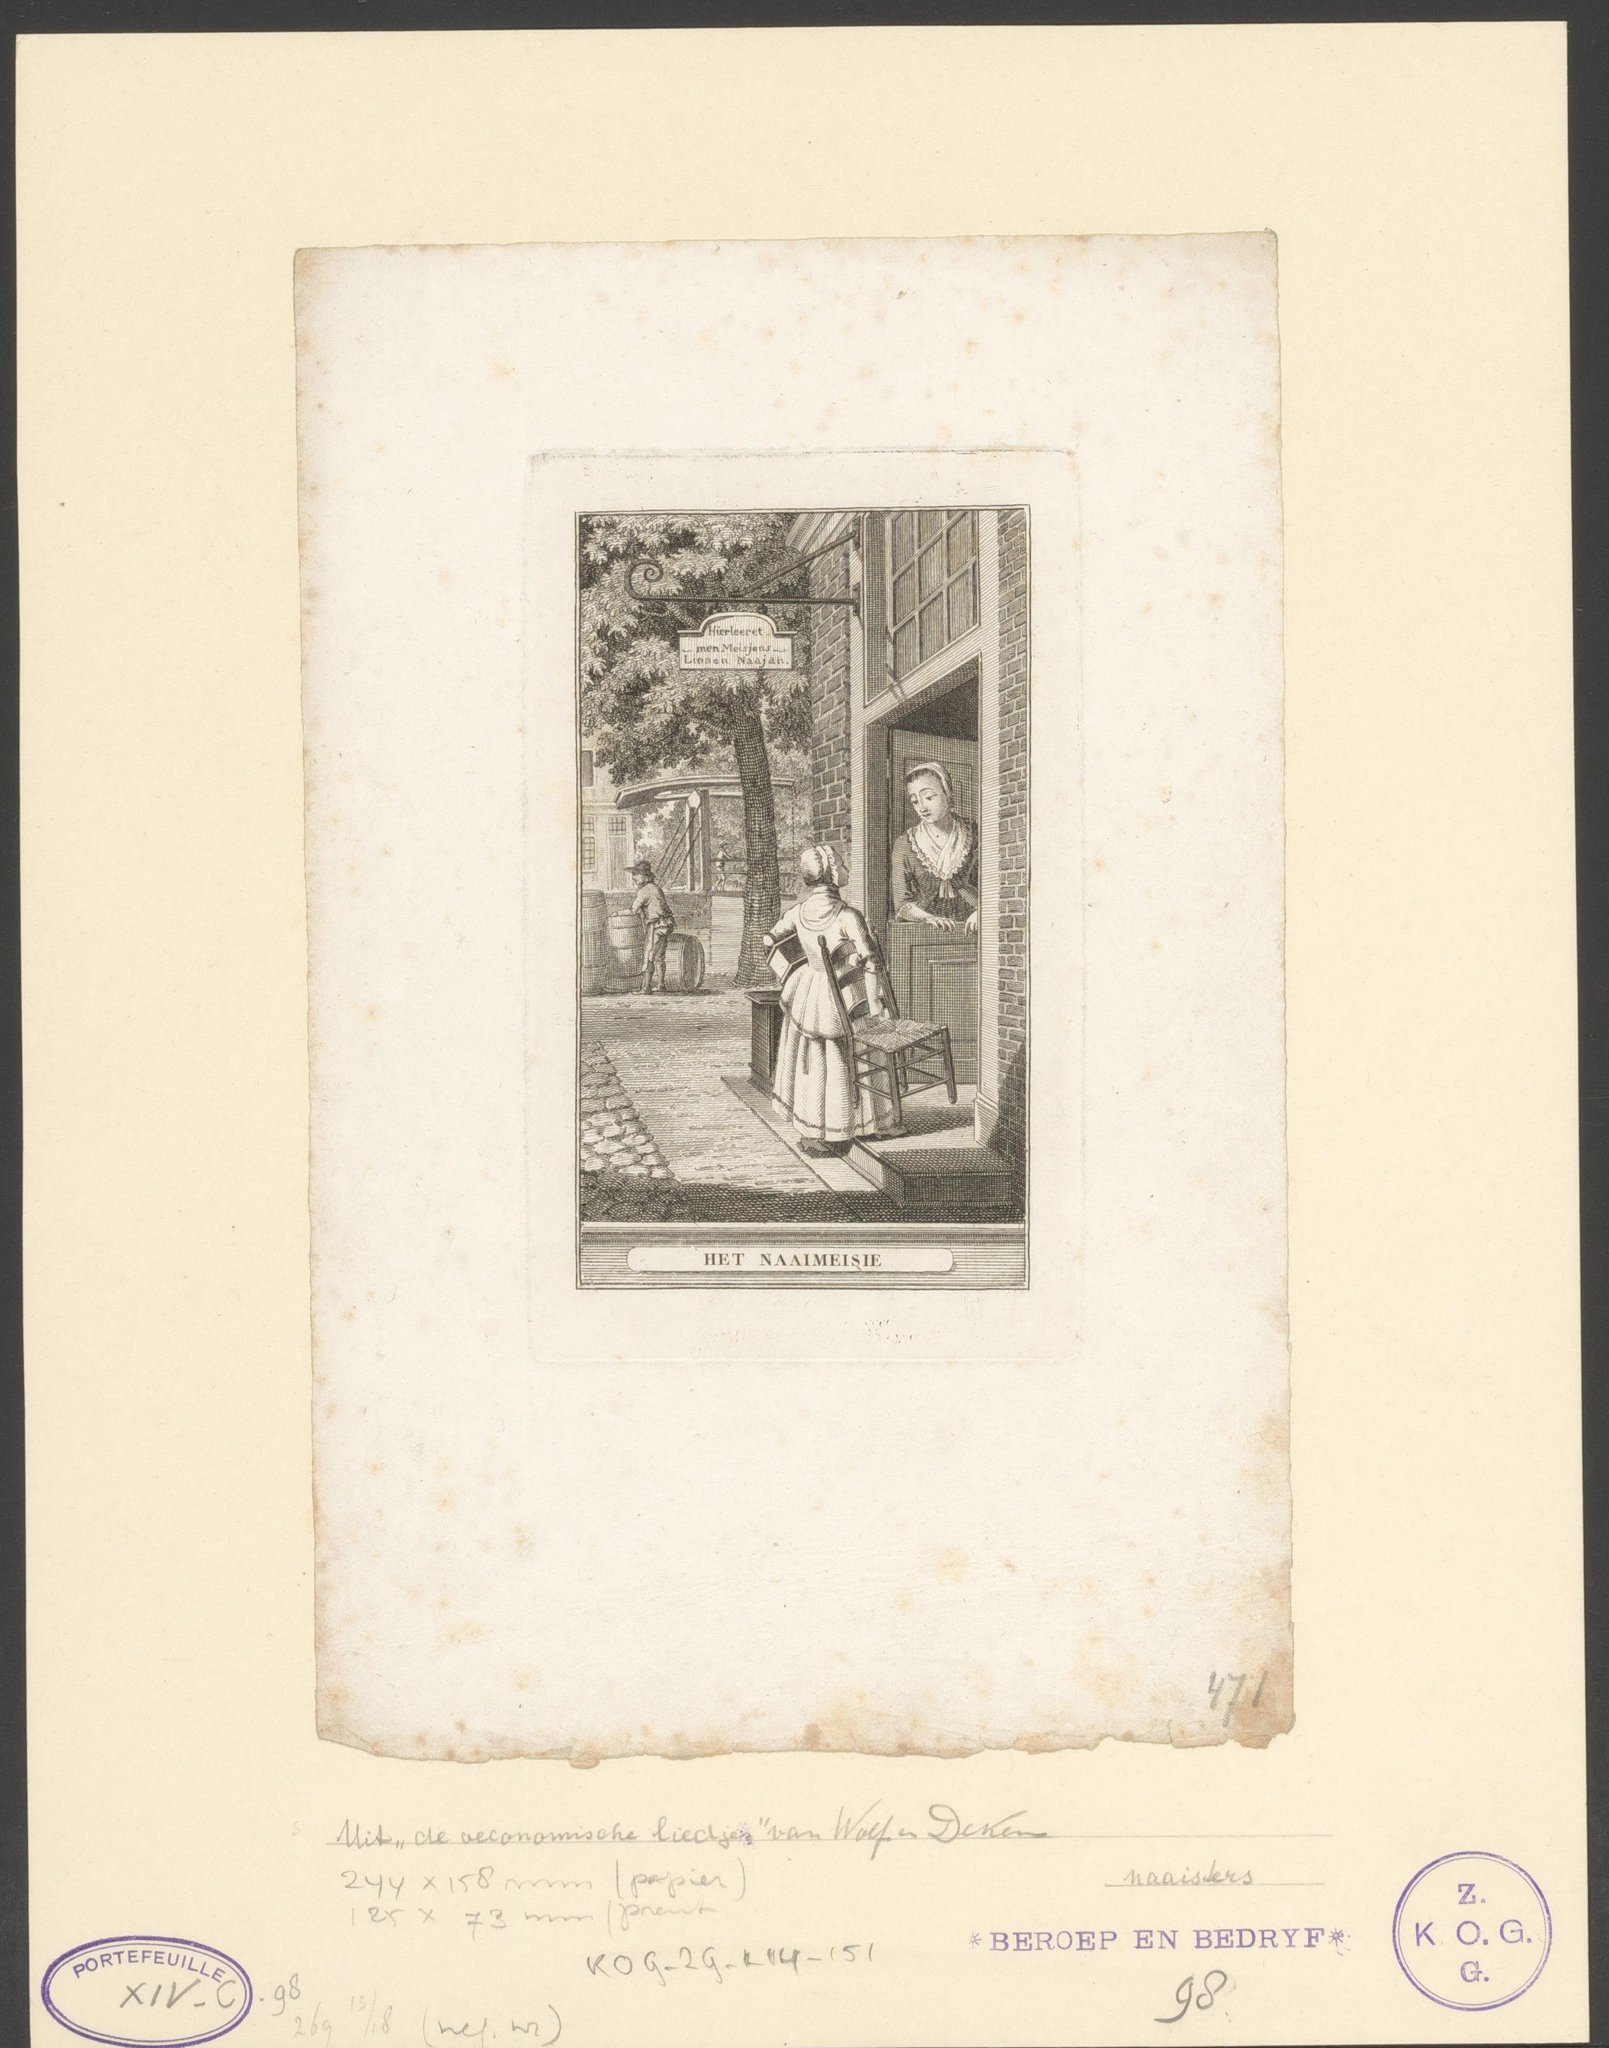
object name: print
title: Het Naaimeisie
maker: Anonymous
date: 1792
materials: paper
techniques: engraving, etching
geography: netherlands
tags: home sewing; repair of clothes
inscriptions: collector's mark, collector's mark: Lugt 1641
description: Een meisje met onder haar ene arm een naaidoos en onder haar andere arm een stoel, bij de deur van een naaischool. Boven de deur een uithangbord met de tekst 'Hier leeret men Meisjes Linnen Naajan.'. De lerares staat in de deuropening. Op de achtergrond een ophaalbruggetje en een man met grote tonnen. Onderwerpsrubrieken binnen de Atlas Zeden en Gewoonten: Beroep en bedrijf. Vrouwelijk beroep en bedrijf. Kleding.